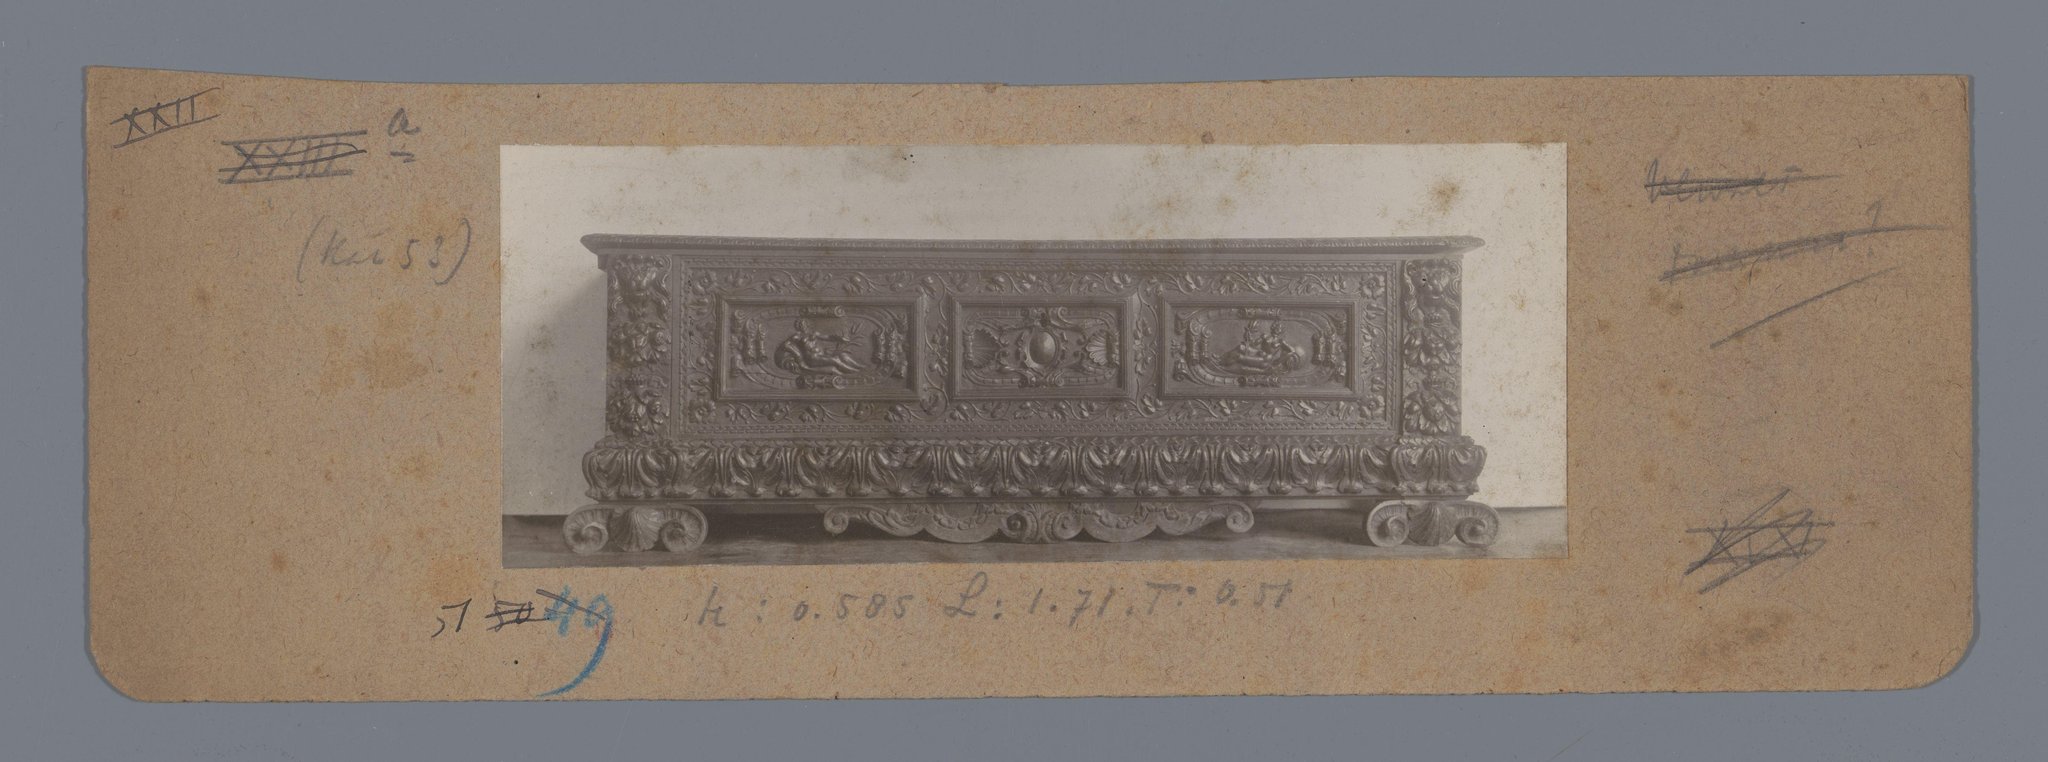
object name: photograph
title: Kist gedecoreerd met twee vrouwfiguren en een cartouche (vermoedelijk) in het Rijksmuseum te Amsterdam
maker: Anonymous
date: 1875-1900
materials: photographic support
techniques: matte daylight collodion silver print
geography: amsterdam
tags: ornament ~ cartouche, chest, coffer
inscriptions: number: ‘XXII (Kat 53) 51’, collector's mark: ‘Instituut voor kunst-nijverheidsonderwijs Gabriël Metsustraat No. 16, Amsterdam’, collector's mark: ‘Kunstnijverheidschool Quellinus Amsterdam Frans Halsstraat 14.’